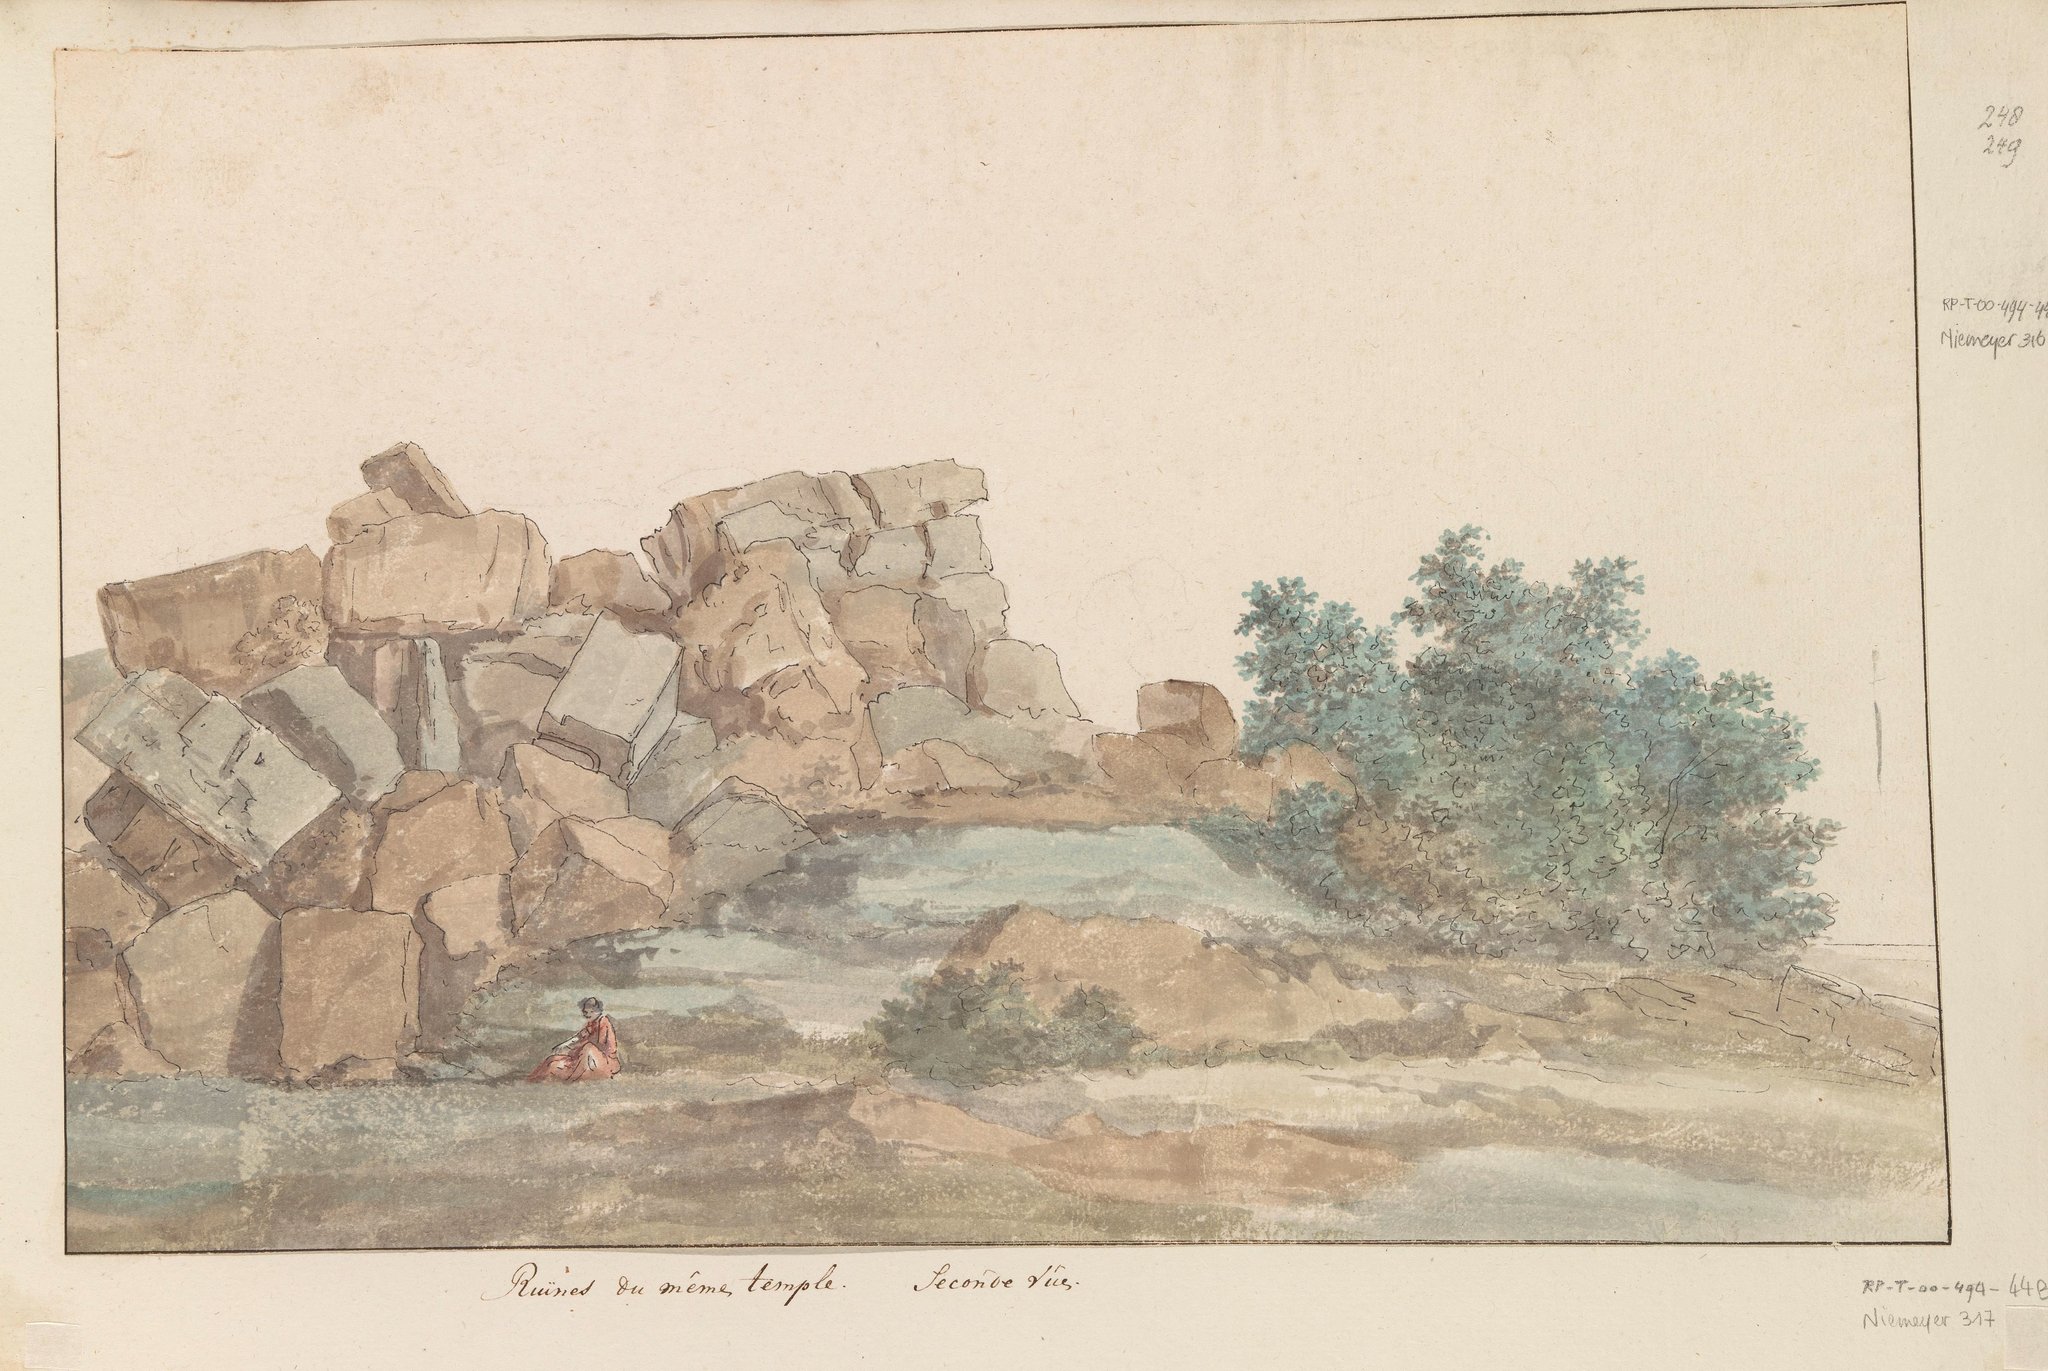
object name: drawing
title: Voyage en Italie, en Sicile et à Malte - 1778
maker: louis ducros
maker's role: draughtsman, print maker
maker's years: 1748-1810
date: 1778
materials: chalk, paper, watercolor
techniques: brush, pen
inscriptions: inscription: ‘No 248 Ruïnes du même temple. Seconde Vue’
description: Tekening uit het album 'Voyage en Italie, en Sicile et à Malte', 1778.